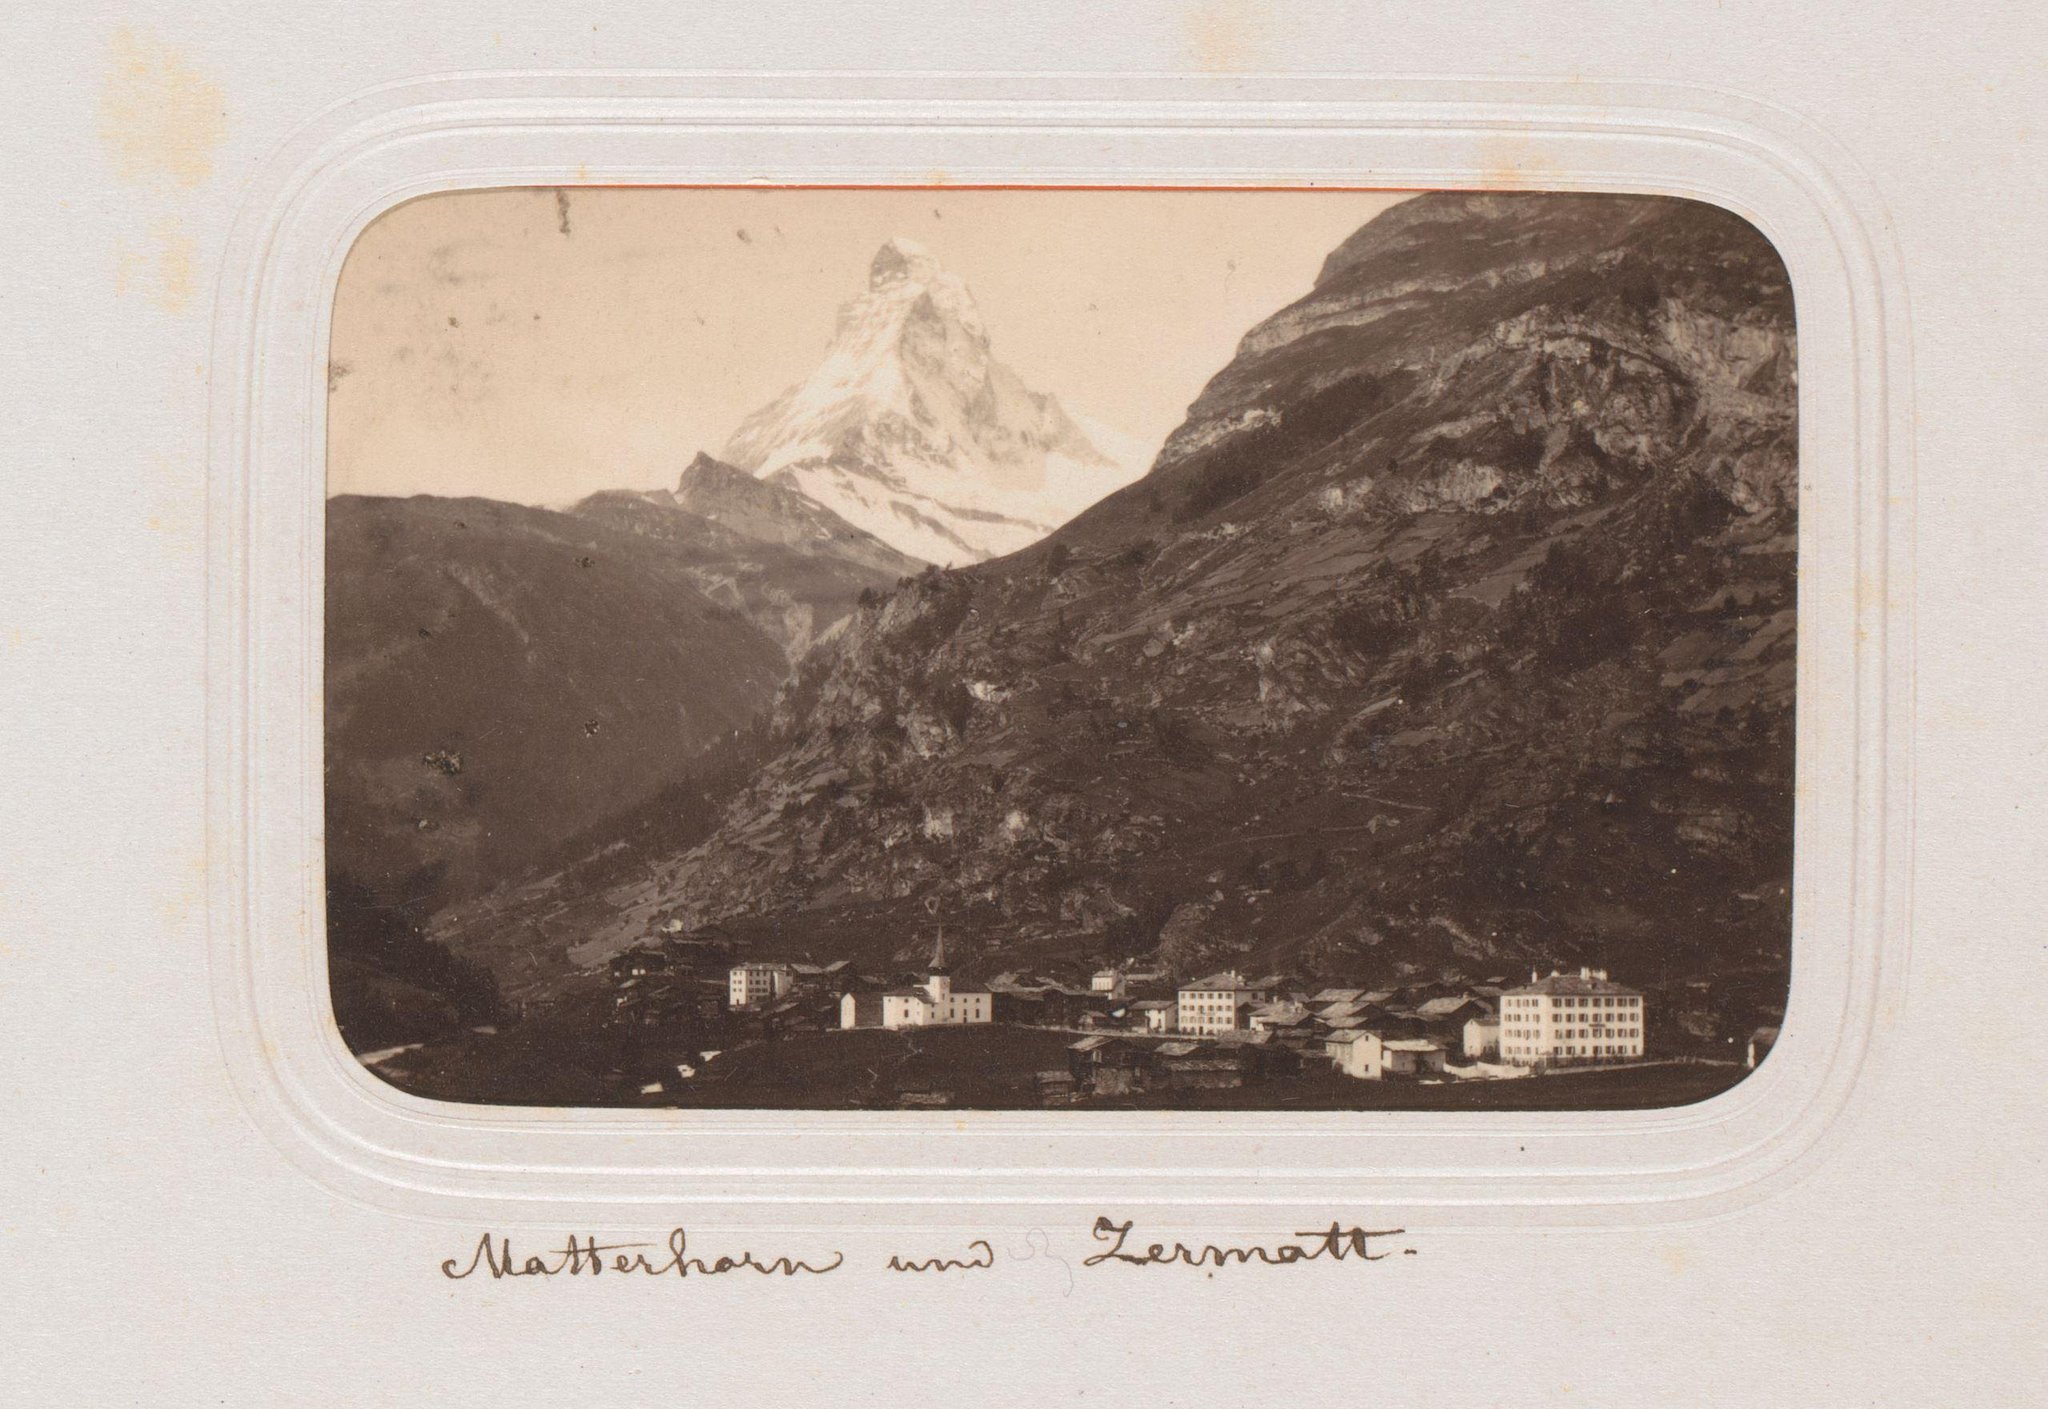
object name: photograph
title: Gezicht op Zermatt met op de achtergrond de Matterhorn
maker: florentin charnaux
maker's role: publisher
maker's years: 1819-1883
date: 1871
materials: cardboard, paper, photographic support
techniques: albumen print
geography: alps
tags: prospect of city, town panorama, silhouette of city, mountains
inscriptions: number: ‘110’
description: Onderdeel van Reisalbum met foto's van bezienswaardigheden in Zwitserland.